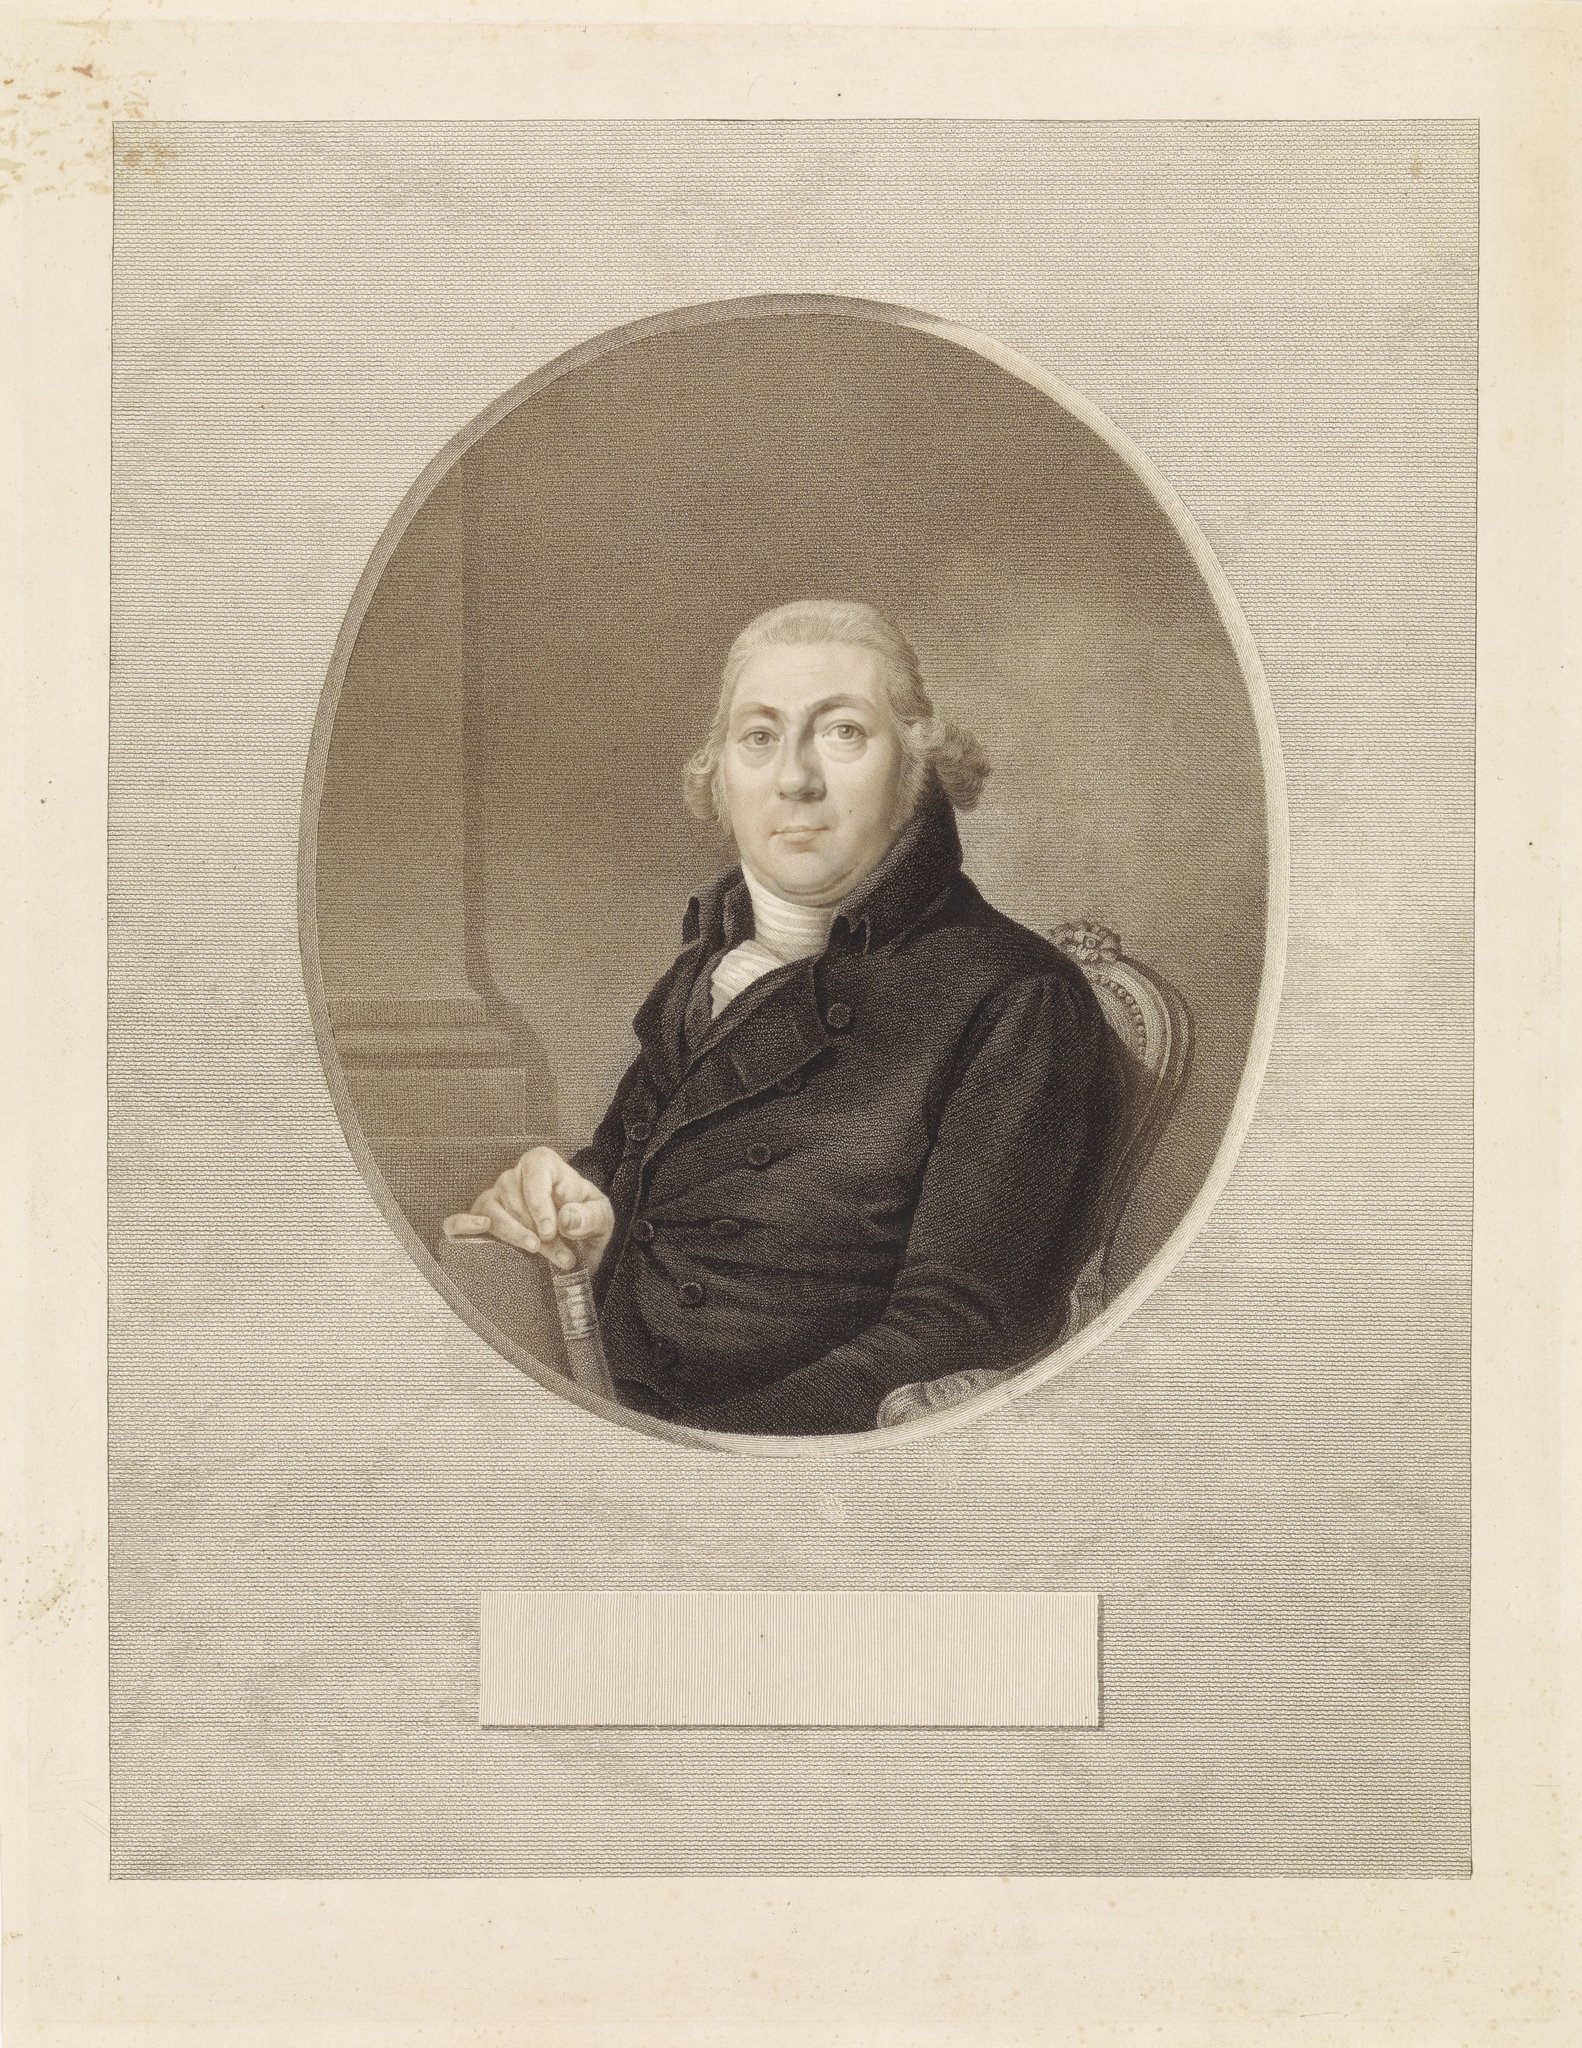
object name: print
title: Portret van Phoebus Hitzerus Themmen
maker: ludwig gottlieb portman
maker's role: print maker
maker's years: 1772-1828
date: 1794-1828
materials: paper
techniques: engraving, lithography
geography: amsterdam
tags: amsterdam, phoebus hitzerus themmen, book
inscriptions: collector's mark: Lugt 2228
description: Portret van de schrijver Phoebus Hitzerus Themmen. In zijn hand houdt hij een boek.